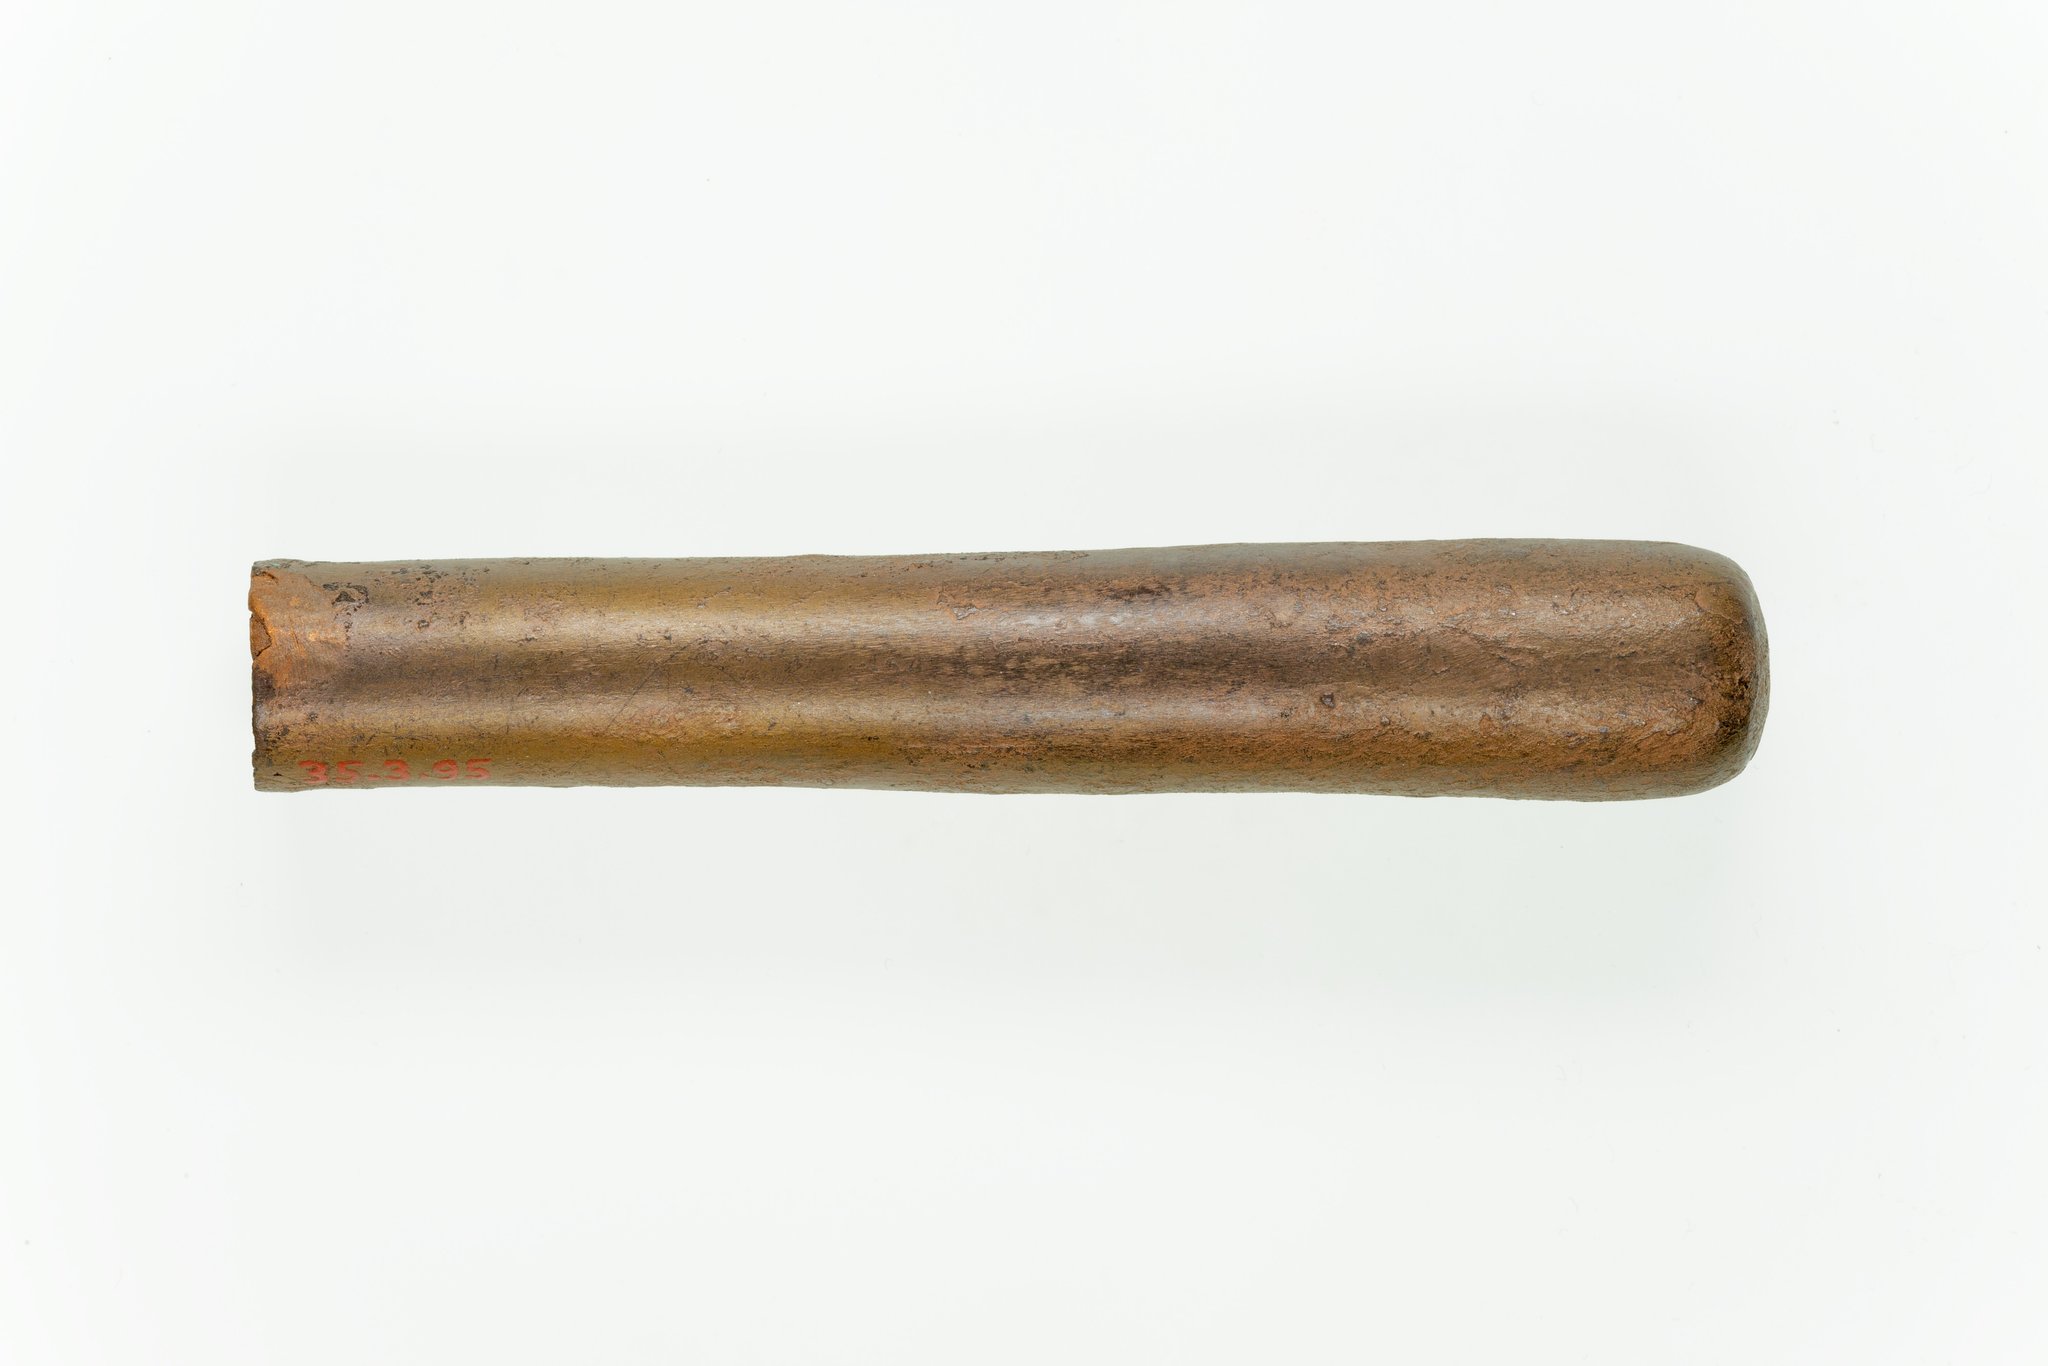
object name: staff stave ferrule, neferkhawet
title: Ferrule from a Stave of Neferkhawet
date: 1504-1447 BCE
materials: bronze, copper alloy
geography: egypt